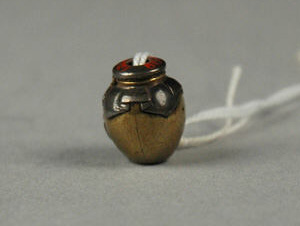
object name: ojime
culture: japanese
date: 1801-1900